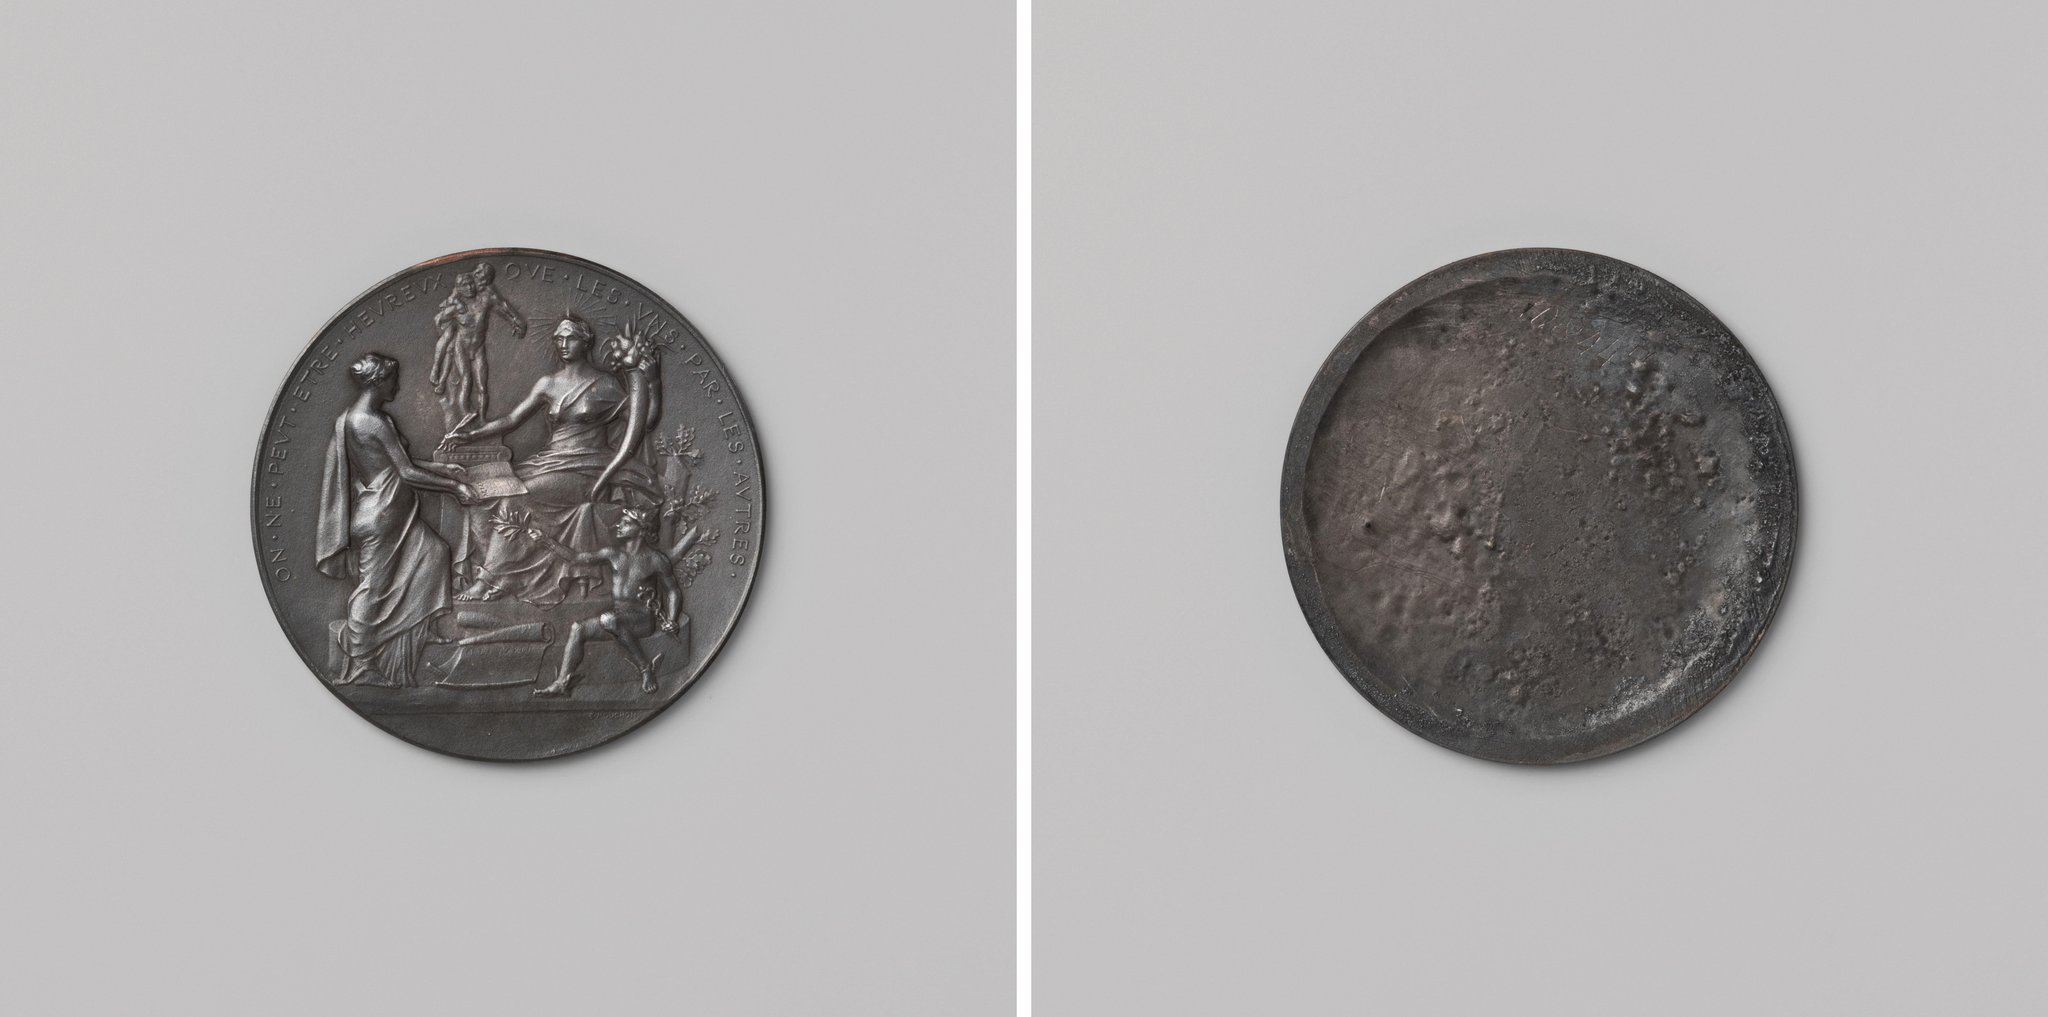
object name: medal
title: Tekenles [?]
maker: louis eugène mouchon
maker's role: medailleur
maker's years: 1843-1914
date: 1887-1888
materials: silver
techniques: casting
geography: paris